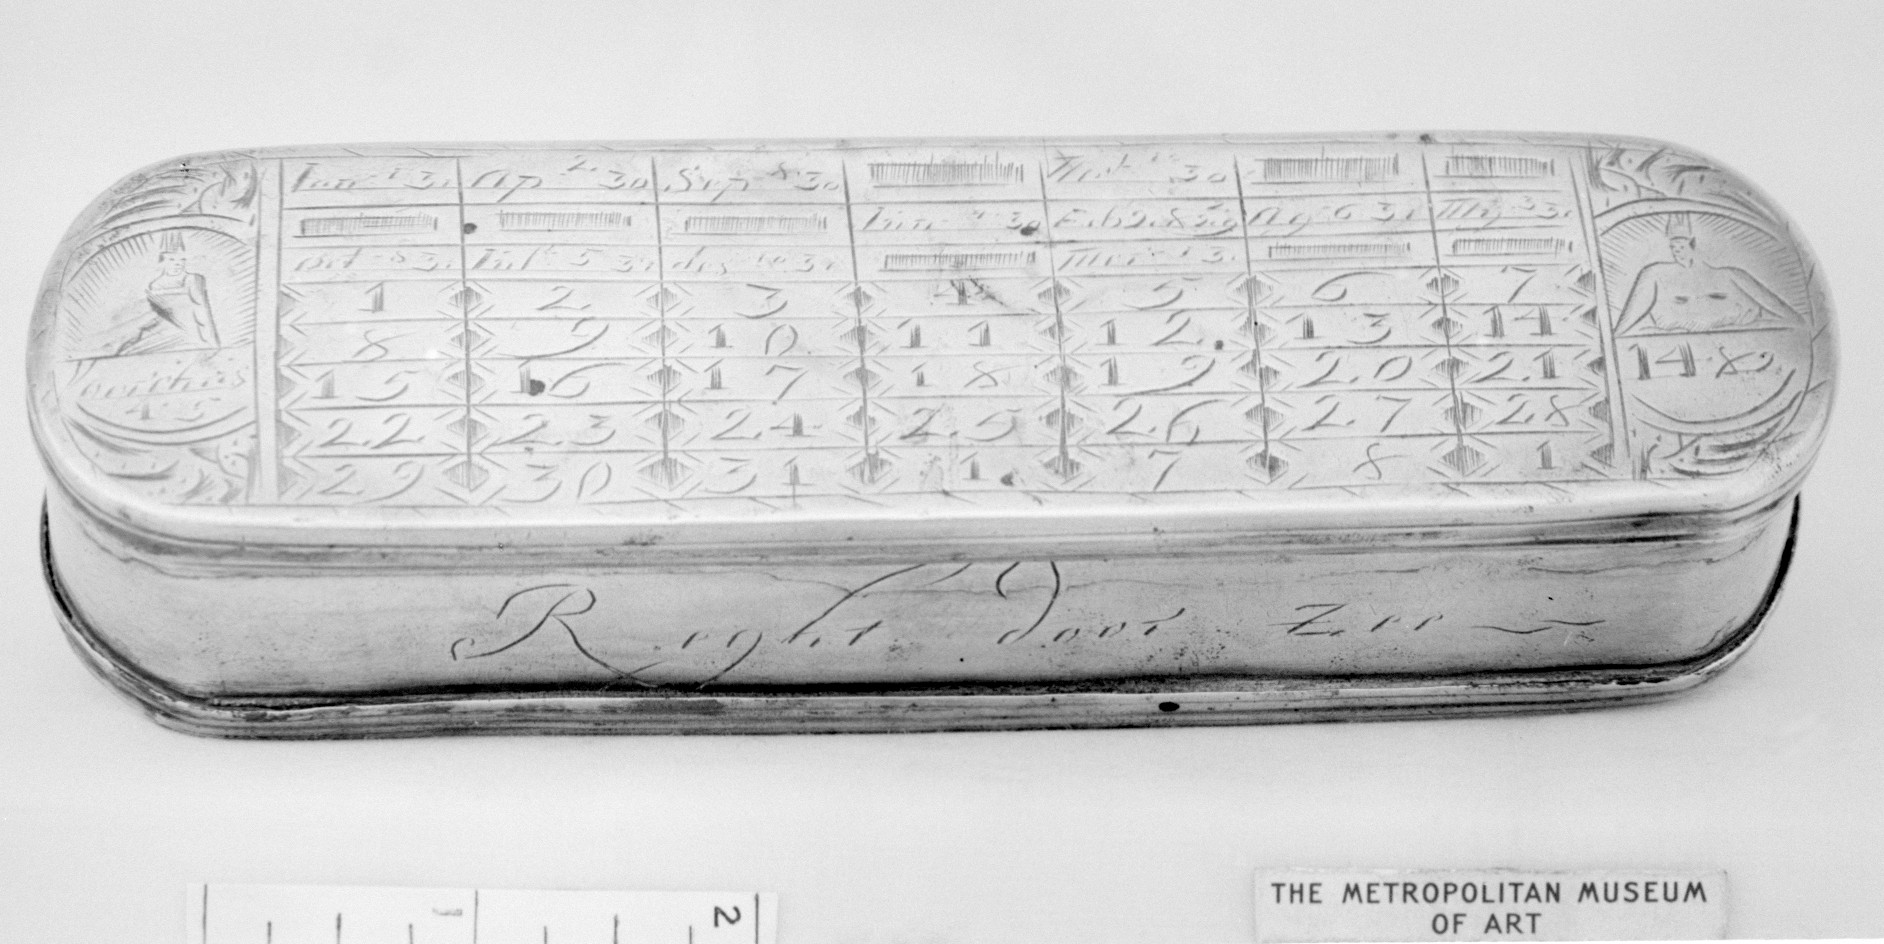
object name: tobacco box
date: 1781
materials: brass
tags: calendars